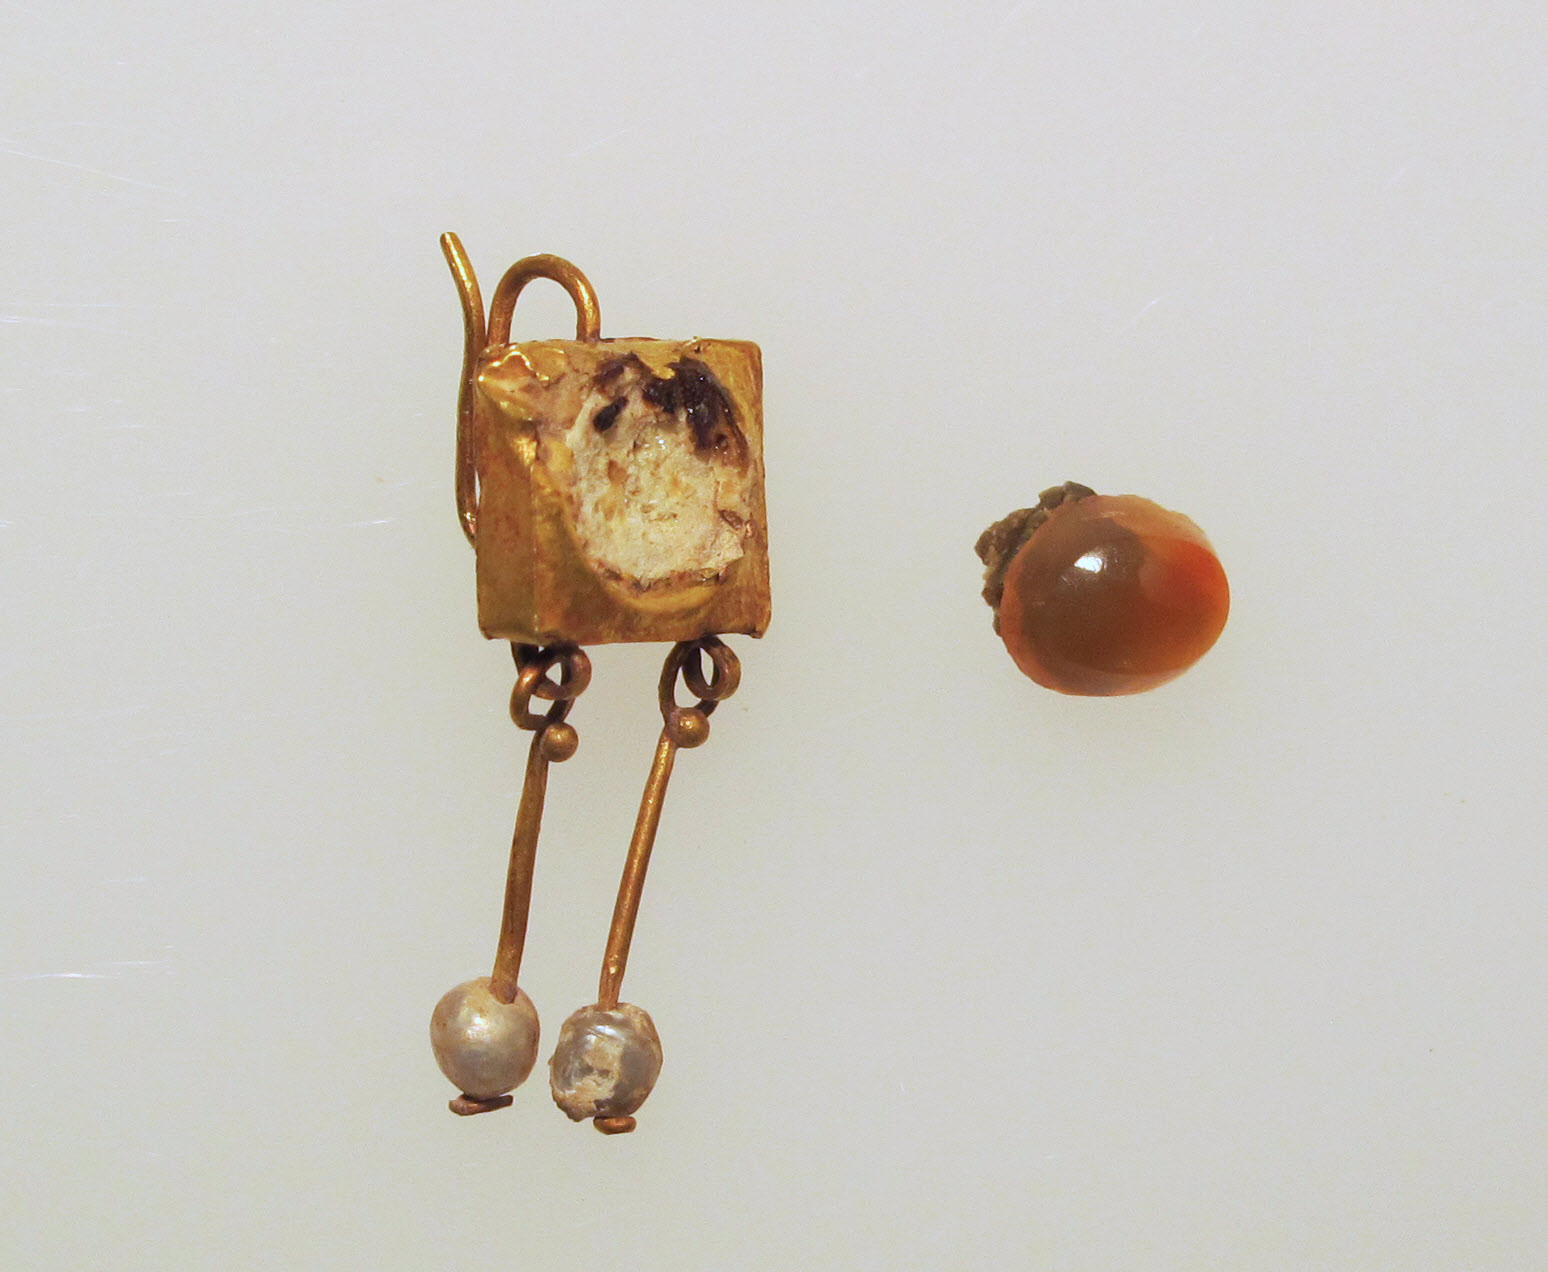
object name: earring hook type with pendant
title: Earring-hook type with pendants of pearls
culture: roman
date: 101-200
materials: stone, gold, pearl